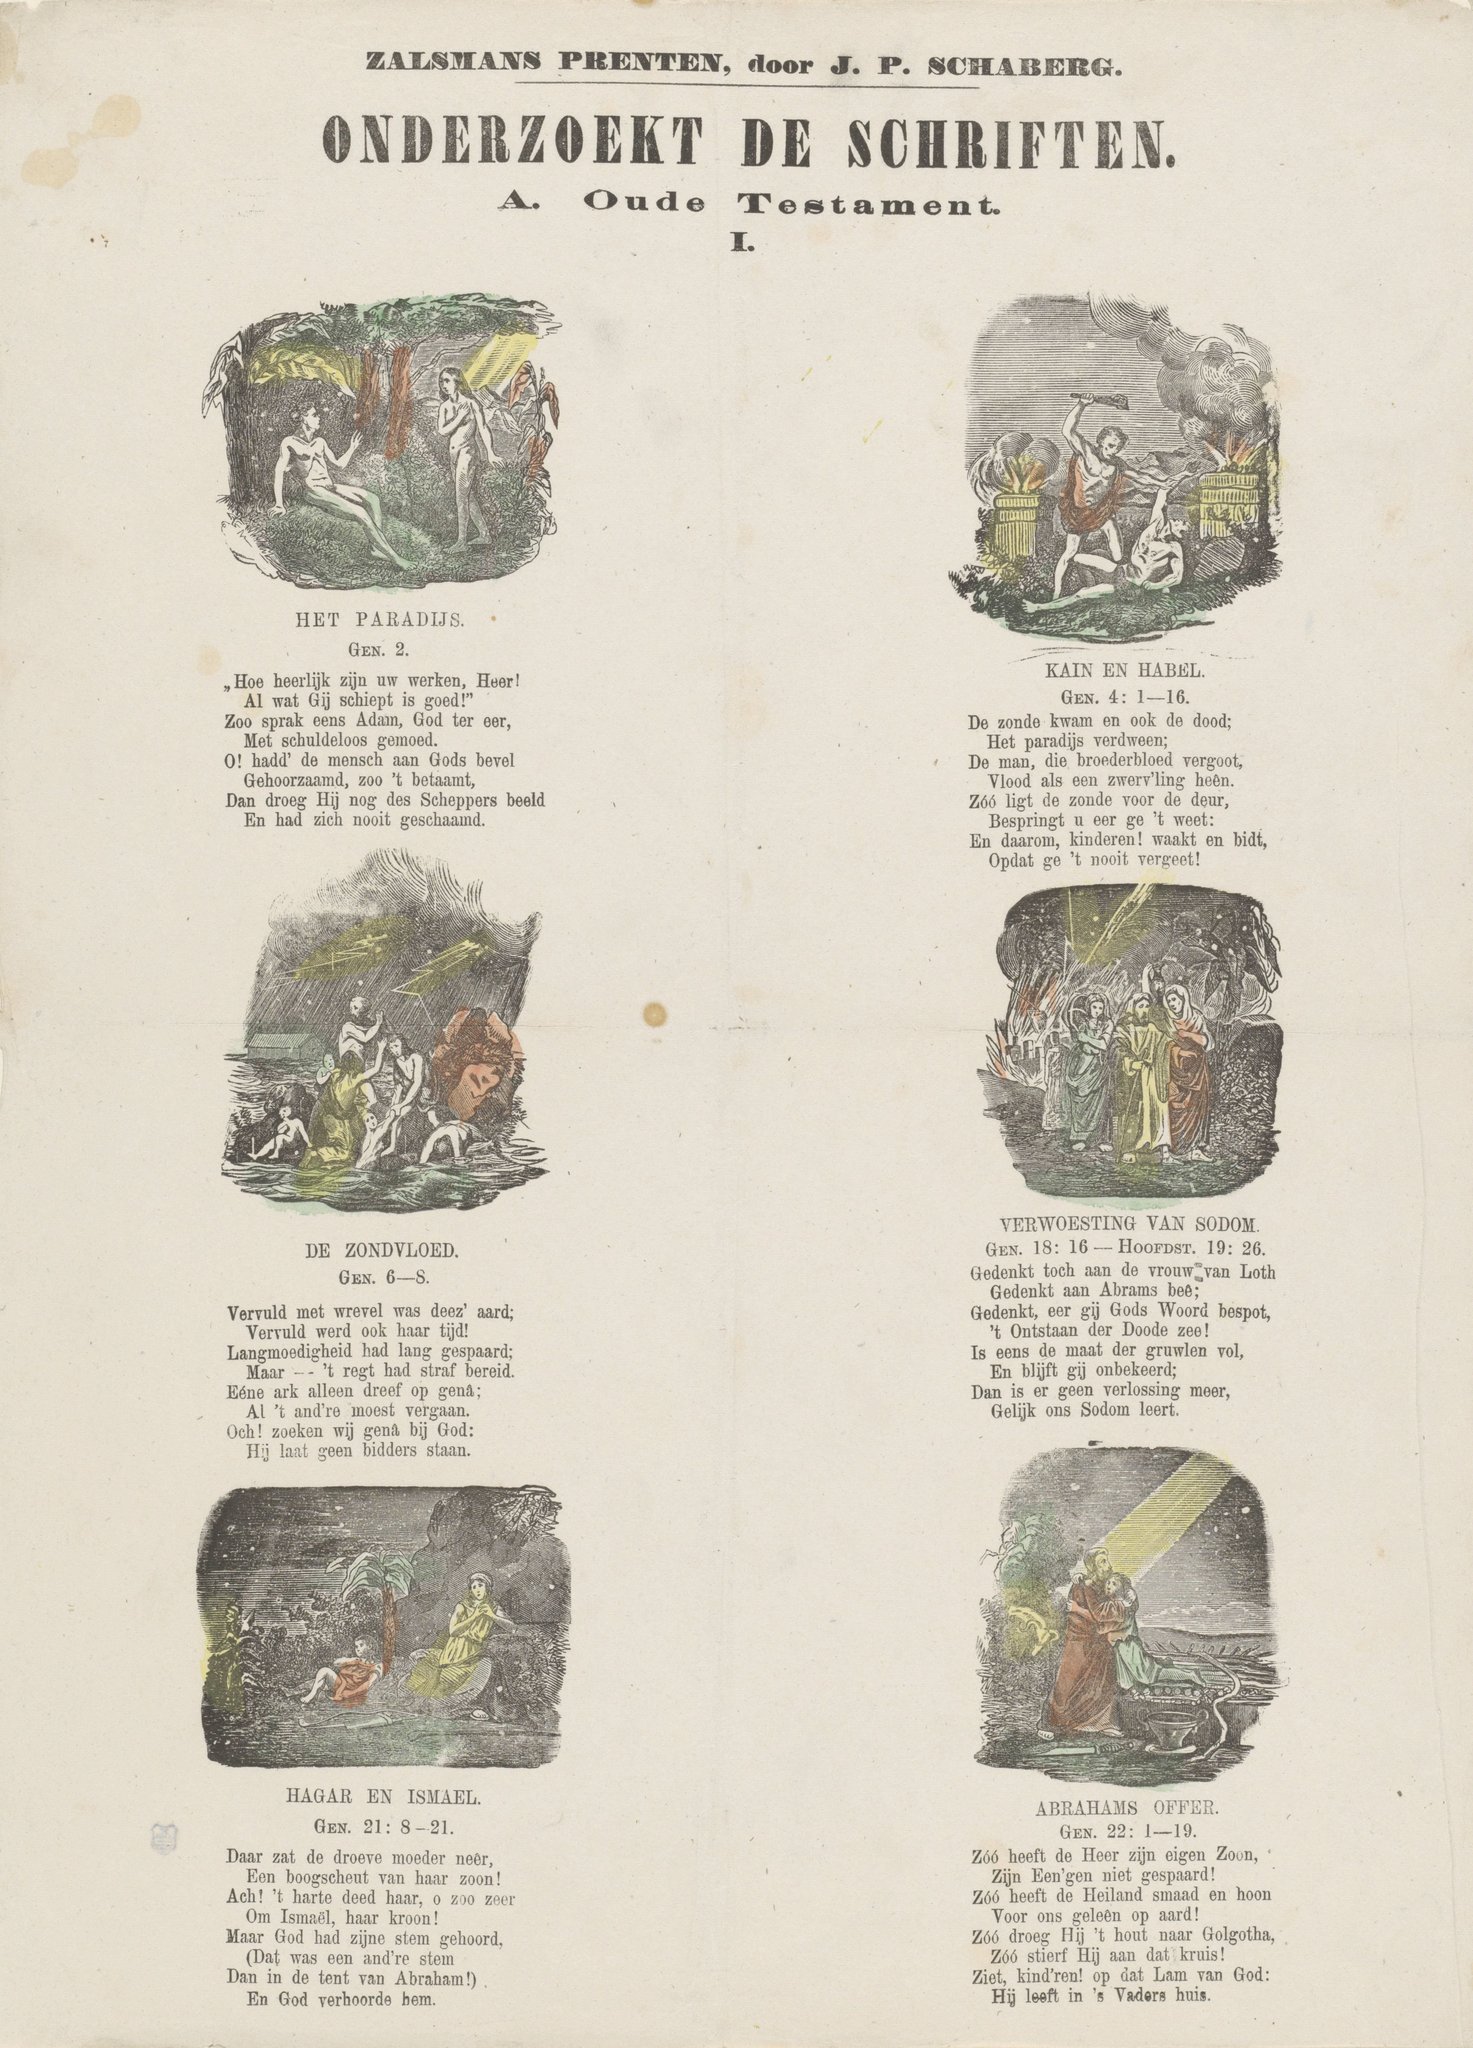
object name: print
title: Onderzoekt de schriften / Oude Testament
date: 1869-1882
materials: paper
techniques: colour, letterpress printing, engraving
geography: netherlands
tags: old testament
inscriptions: collector's mark: Lugt 2760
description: Blad met 6 voorstellingen van verhalen uit het Oude Testament. Onder elke voorstelling een achtregelig vers en een verwijzing naar de bijbehorende Bijbeltekst. Genummerd midden boven: I.